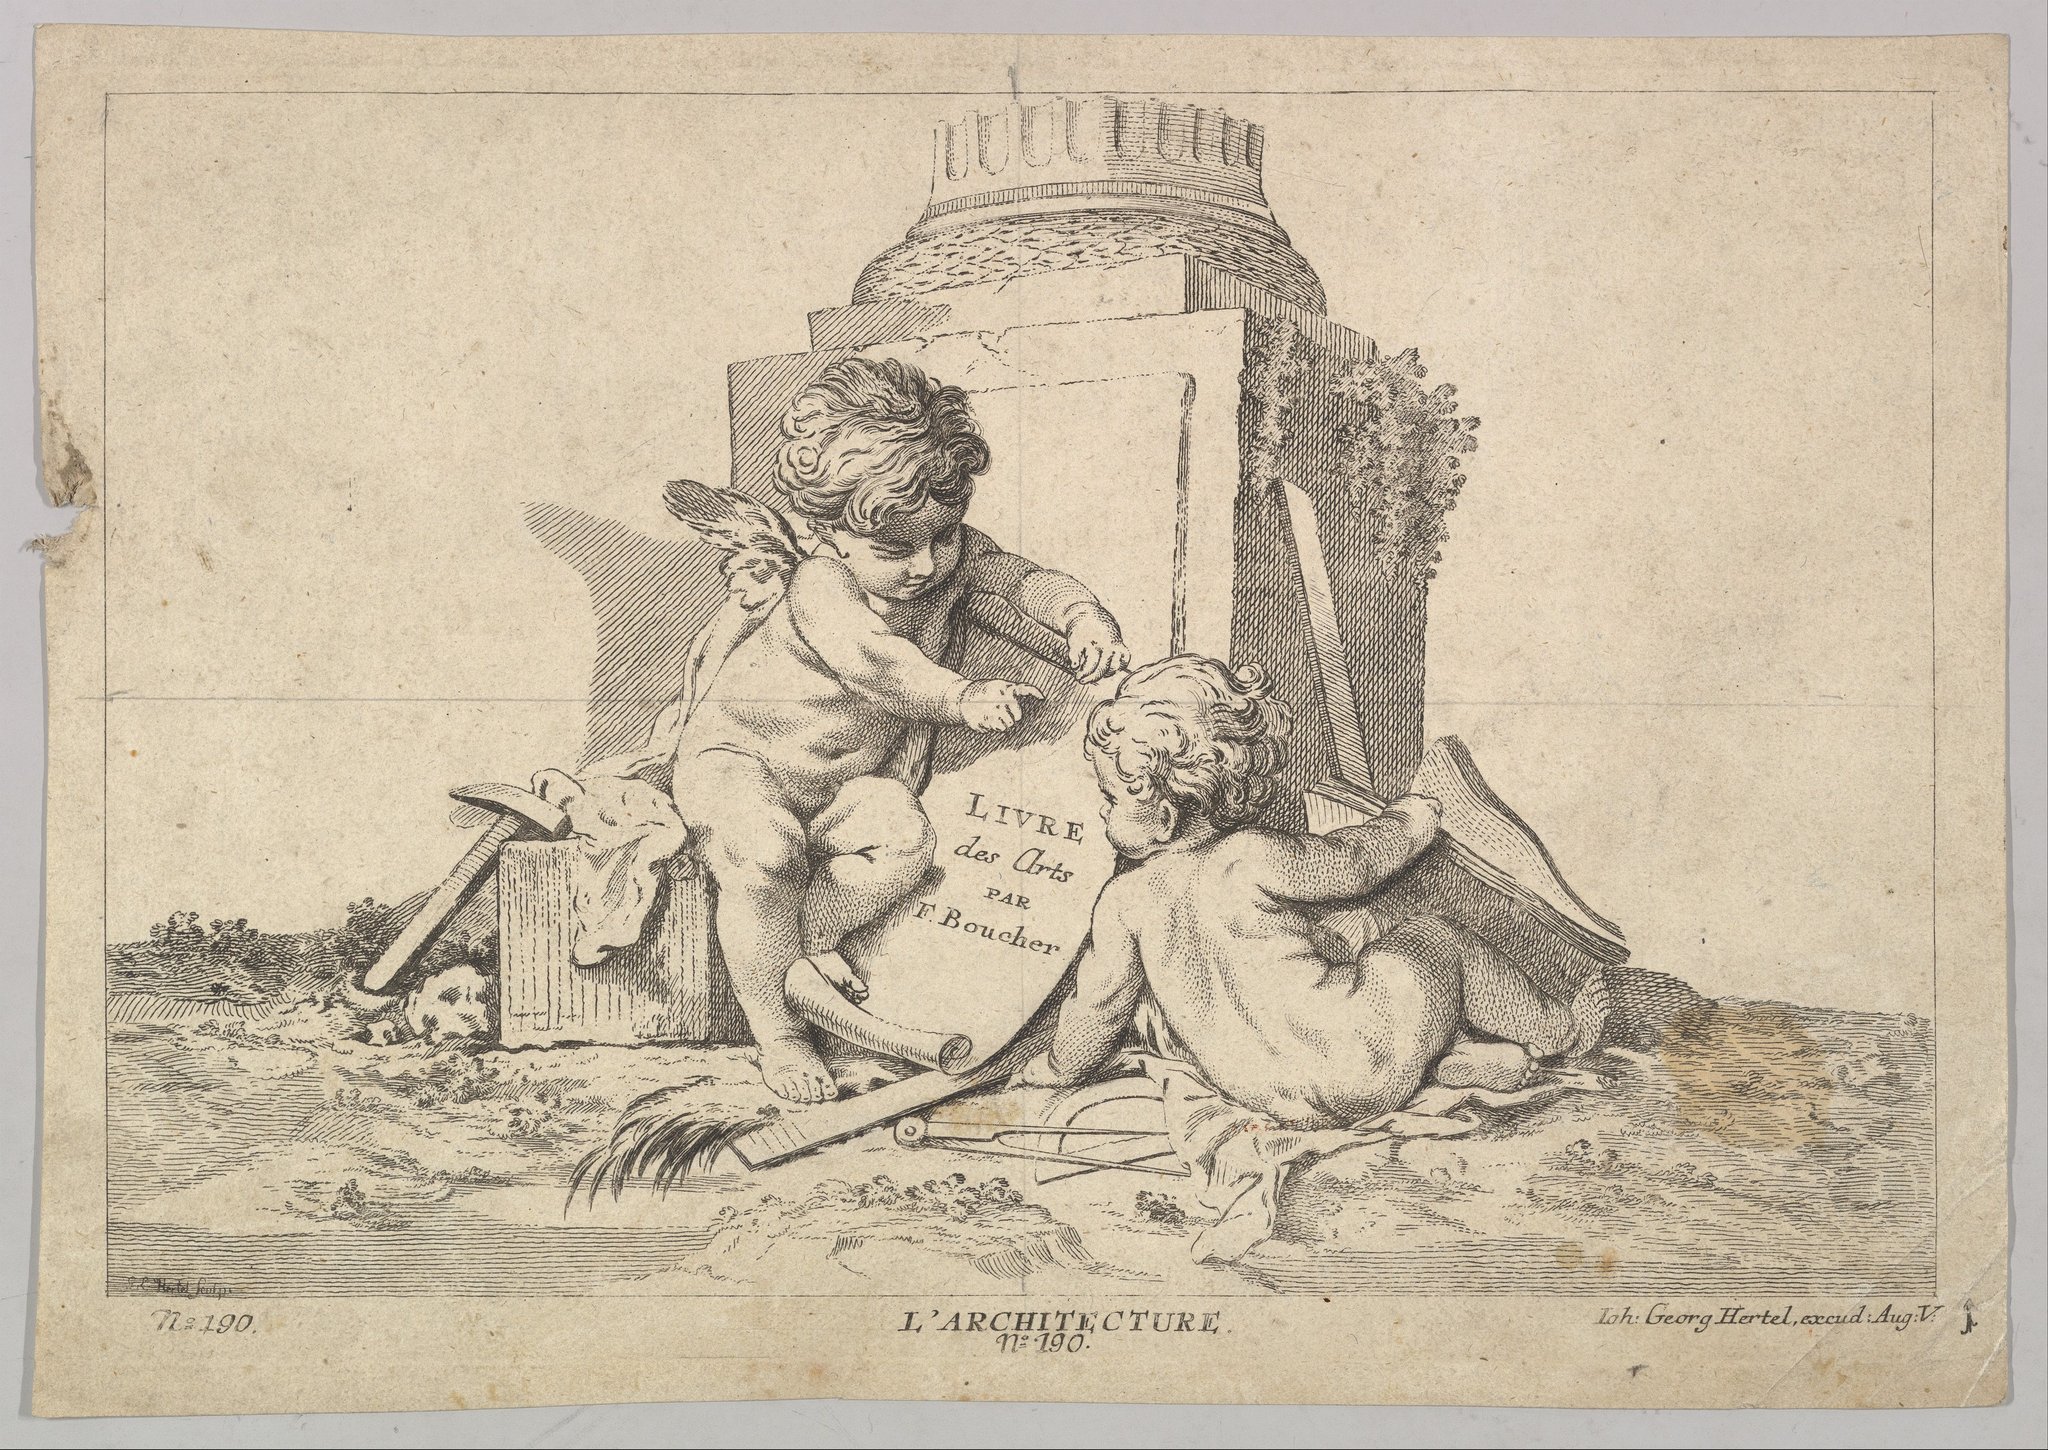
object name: print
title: Architecture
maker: johann georg hertel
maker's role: artist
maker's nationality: german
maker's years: 1695-1775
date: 1701-1800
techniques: engraving, etching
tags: architecture,putti